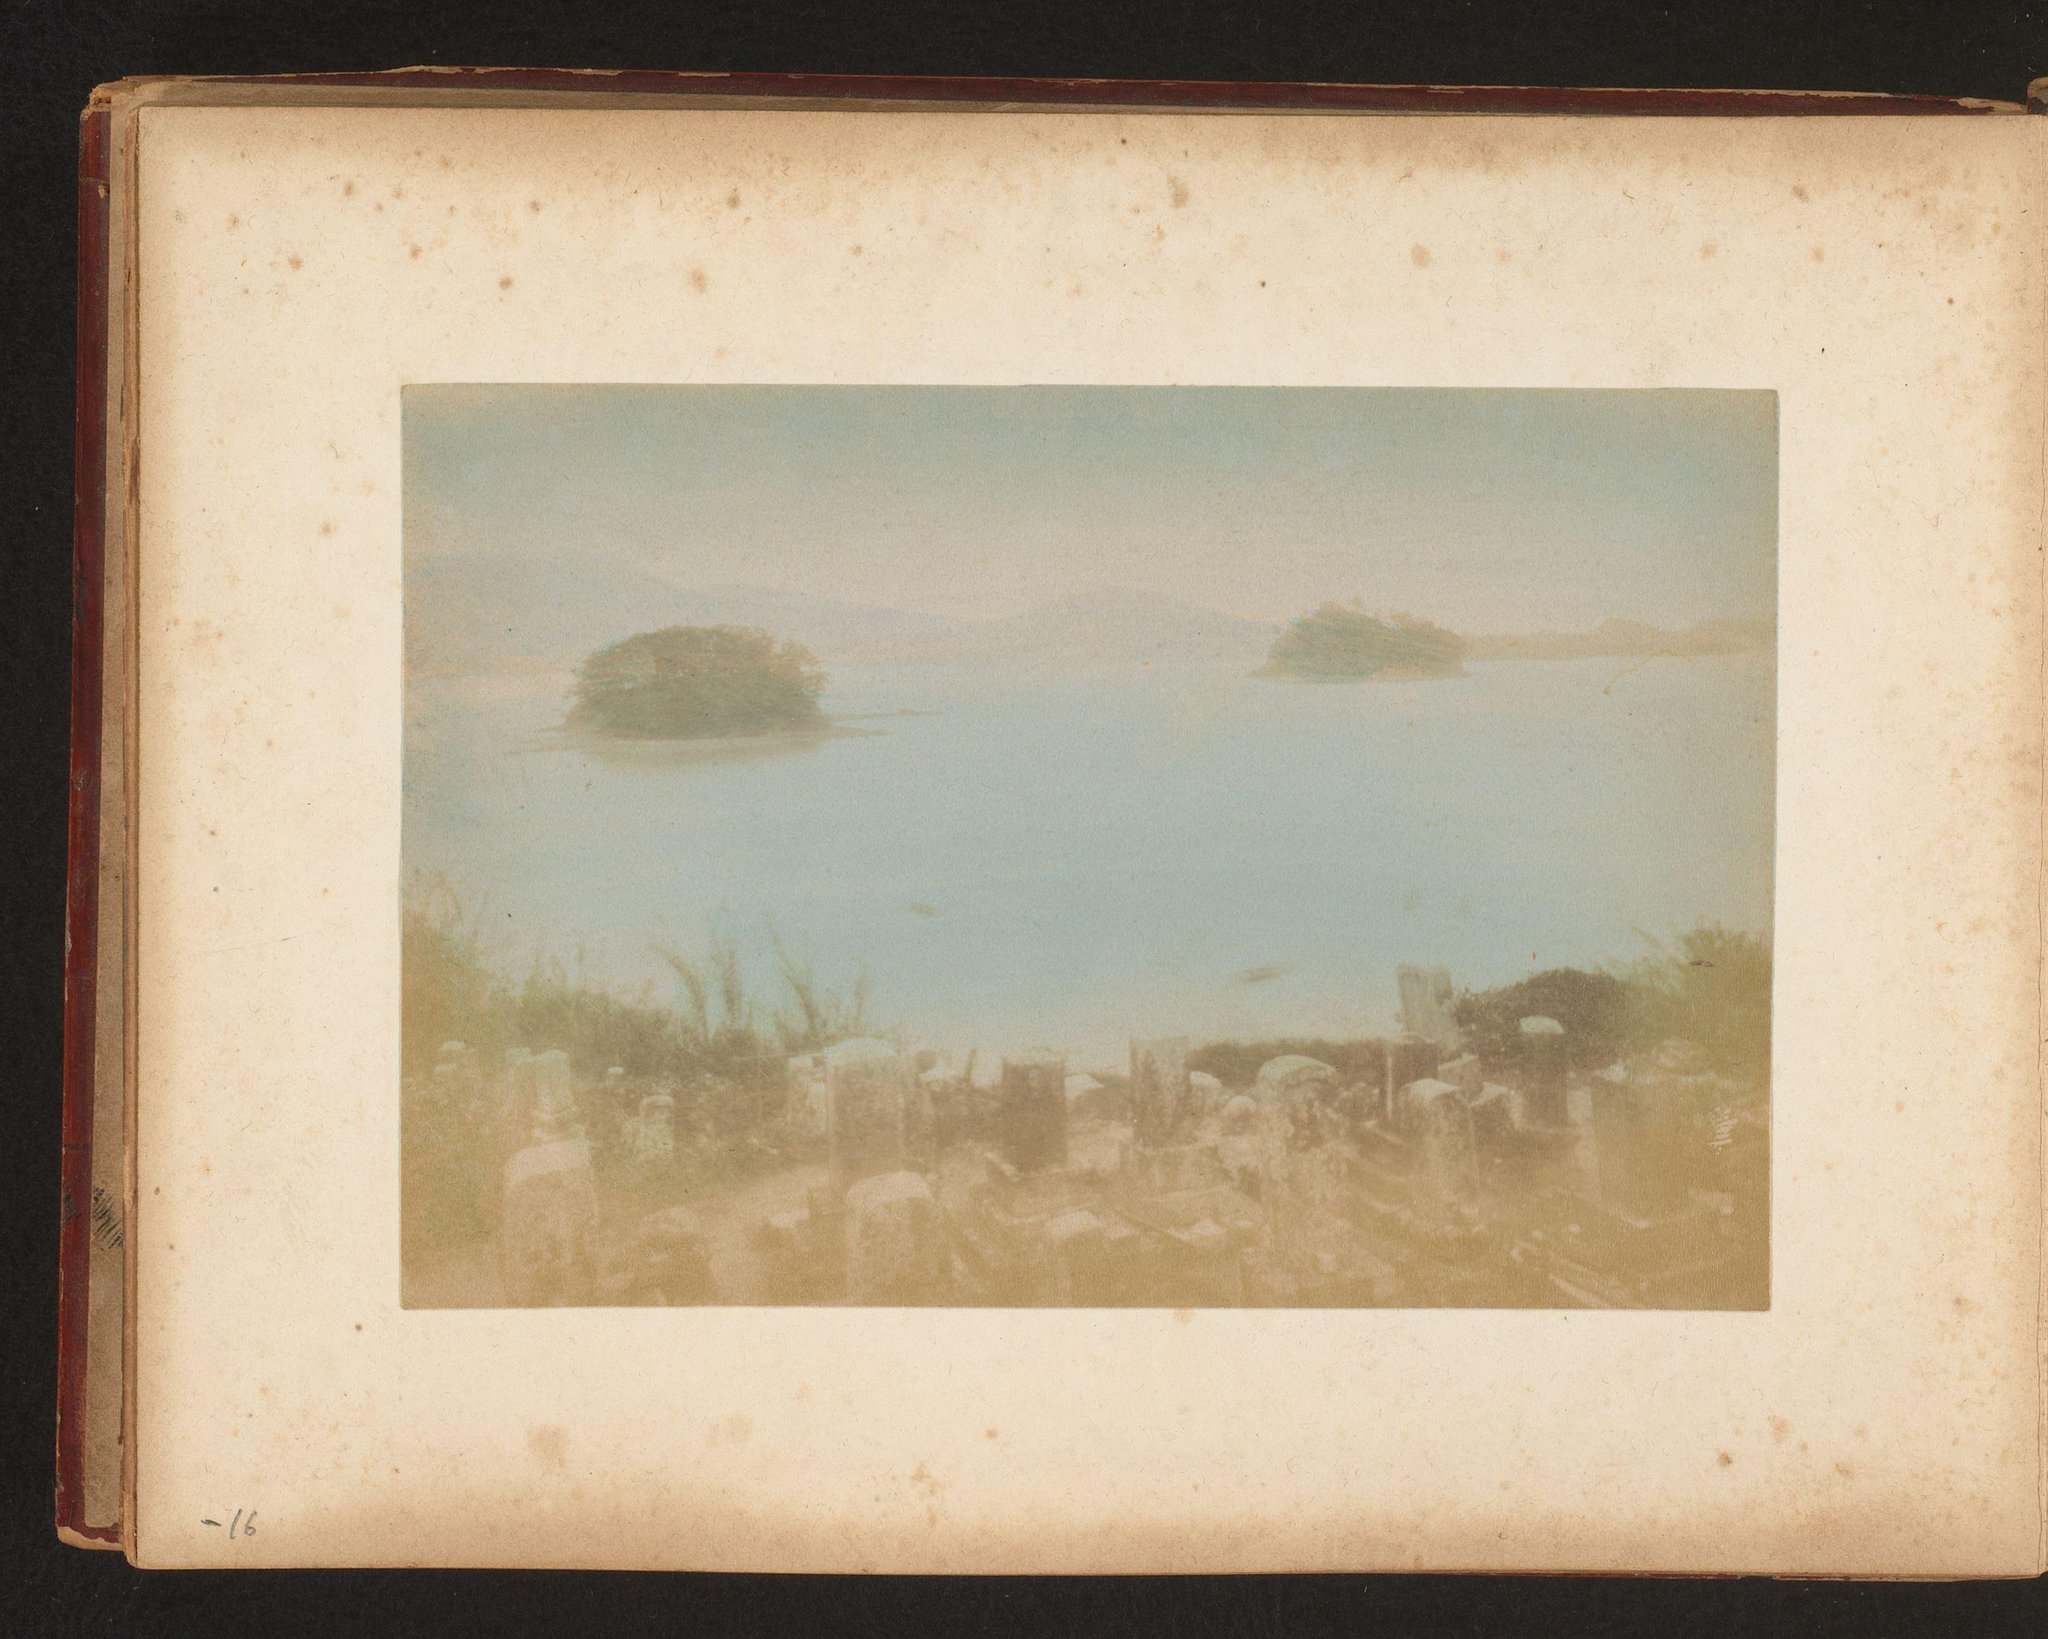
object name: album leaf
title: Uitzicht over een lagune in Japan vanaf een klif, op de voorgrond enkele grafzerken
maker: Anonymous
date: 1851-1900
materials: paper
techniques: albumen print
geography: japan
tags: haff, lagoon created by sand, shingle bank ~ coast, gravestone, tombstone, japan